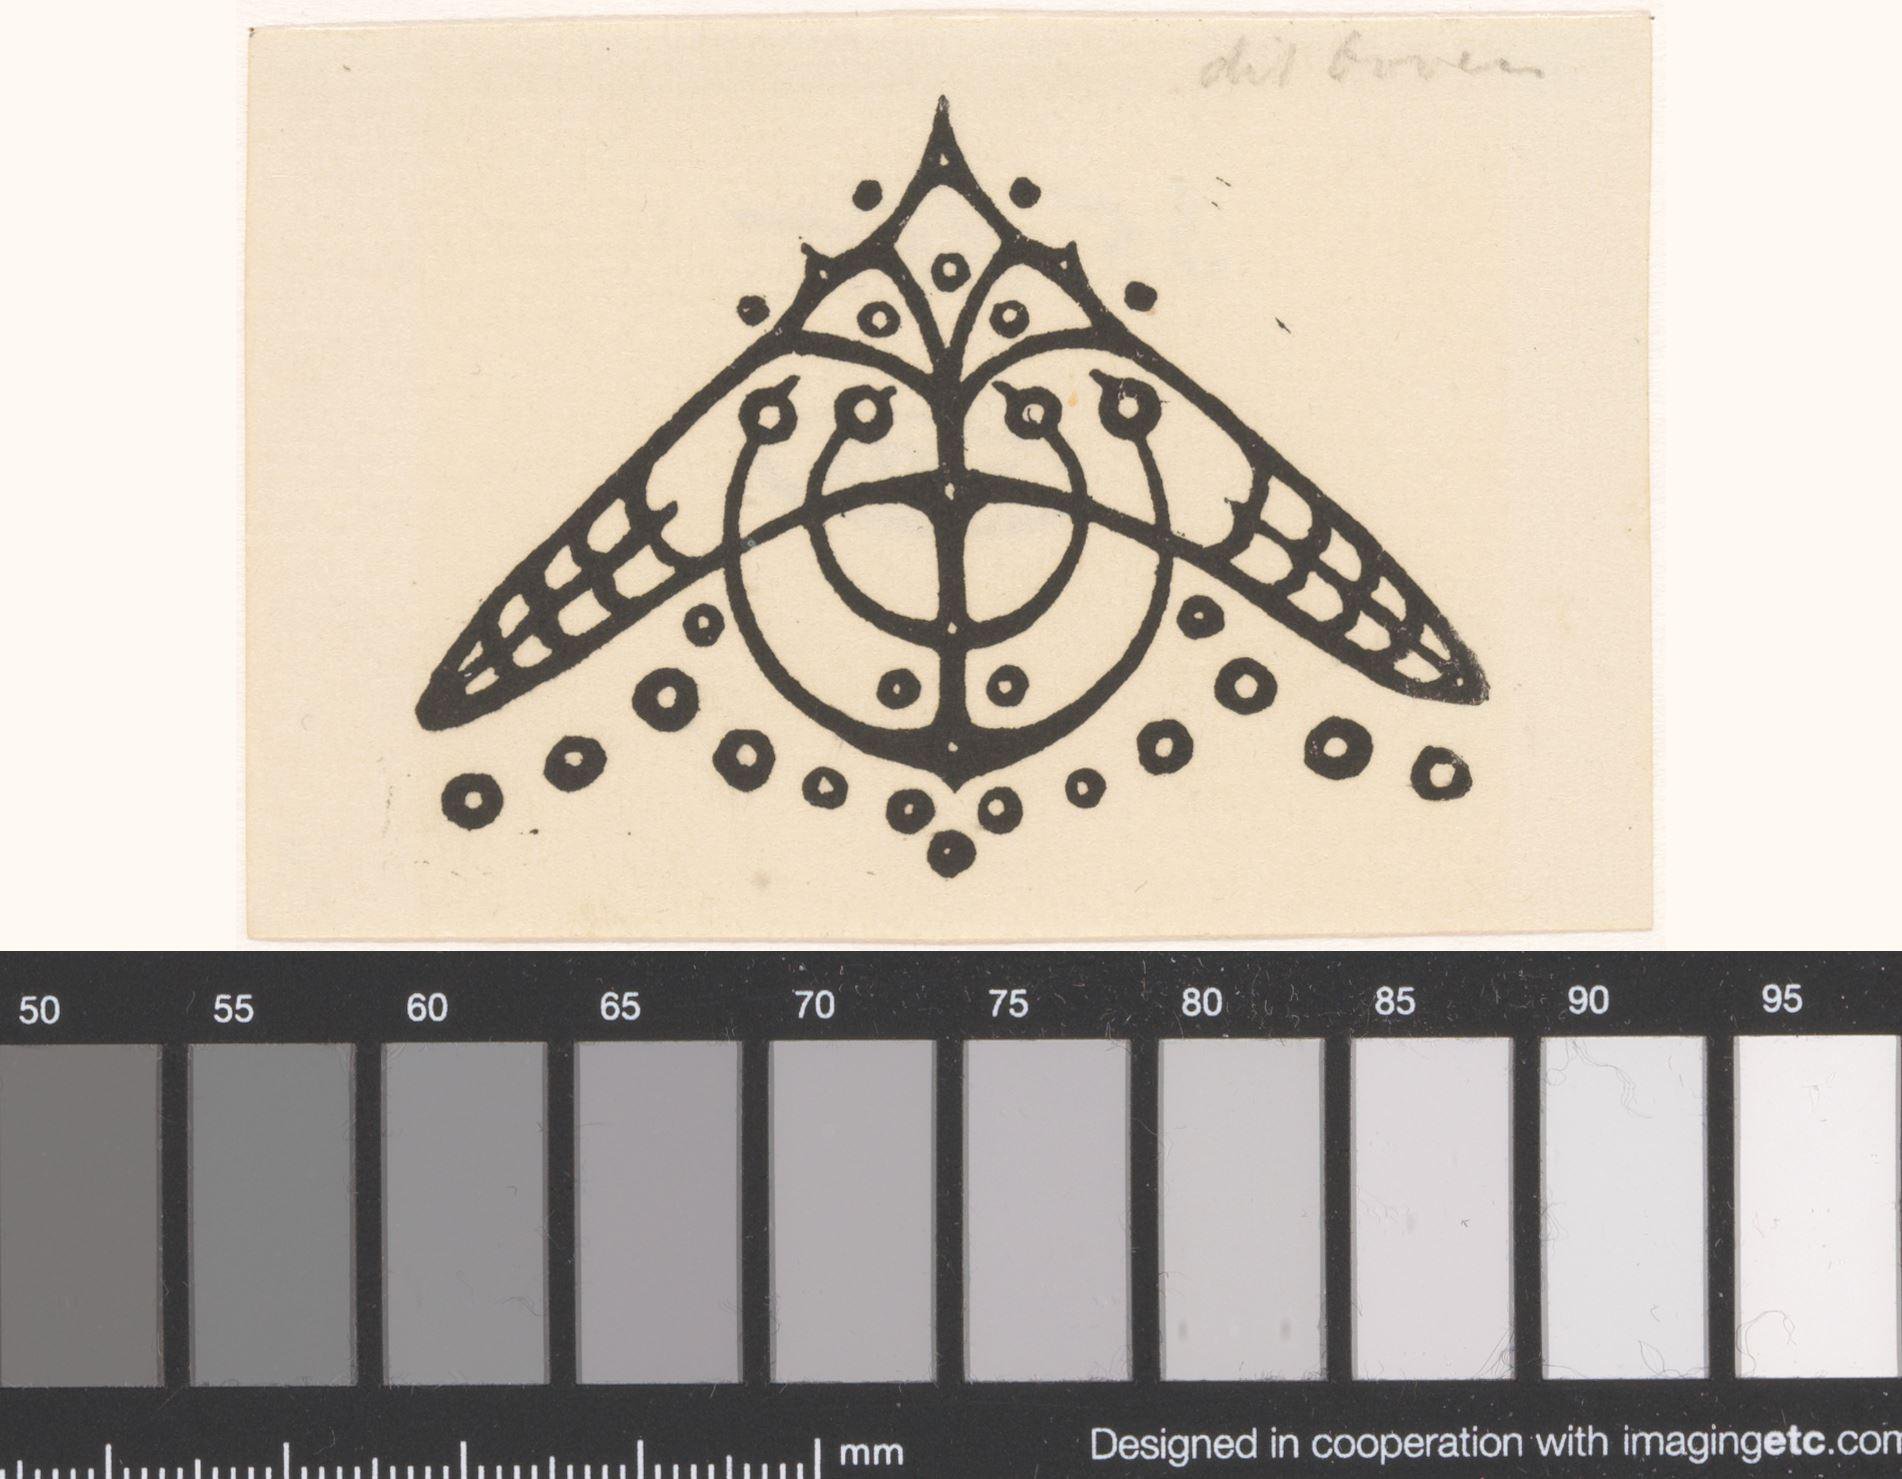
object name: print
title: Ornament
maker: julie de graag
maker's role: draughtsman, print maker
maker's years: 1877-1924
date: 1887-1924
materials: paper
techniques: woodcut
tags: ornaments ~ art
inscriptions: collector's mark: Lugt 2228, inscription: ‘dit boven’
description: Een symmetrisch ornament met plant- en diermotieven.